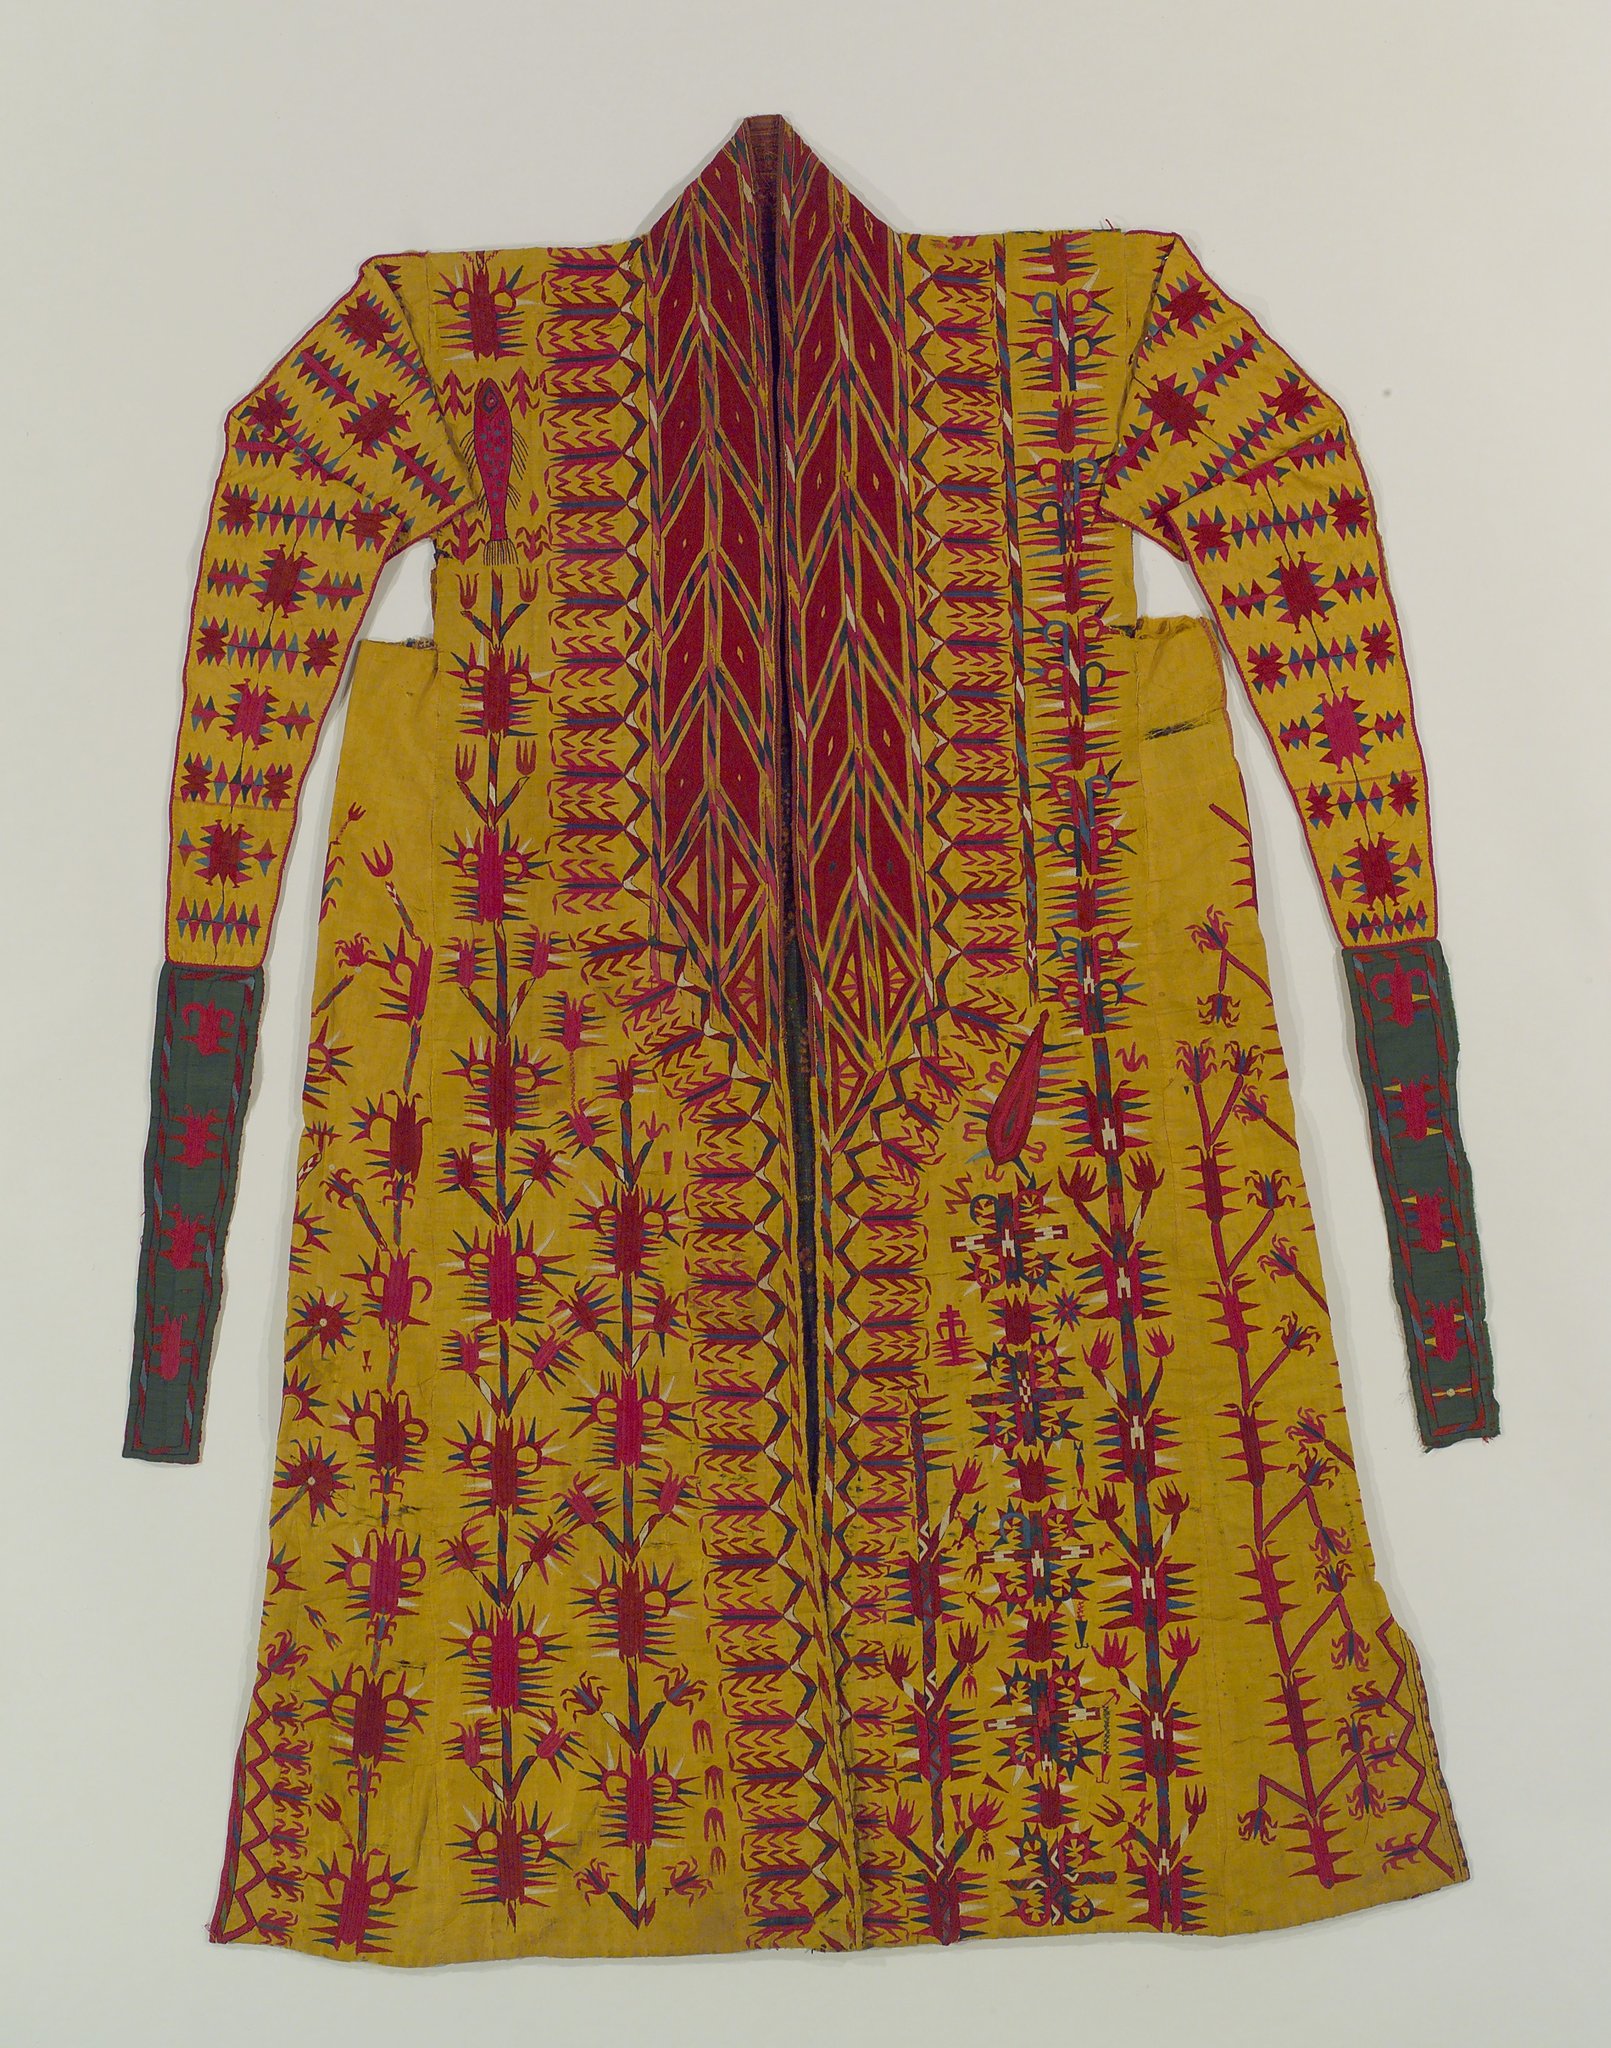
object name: robe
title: Robe (Chyrpy)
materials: cotton, silk, thread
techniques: embroidery, lining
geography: turkmenistan